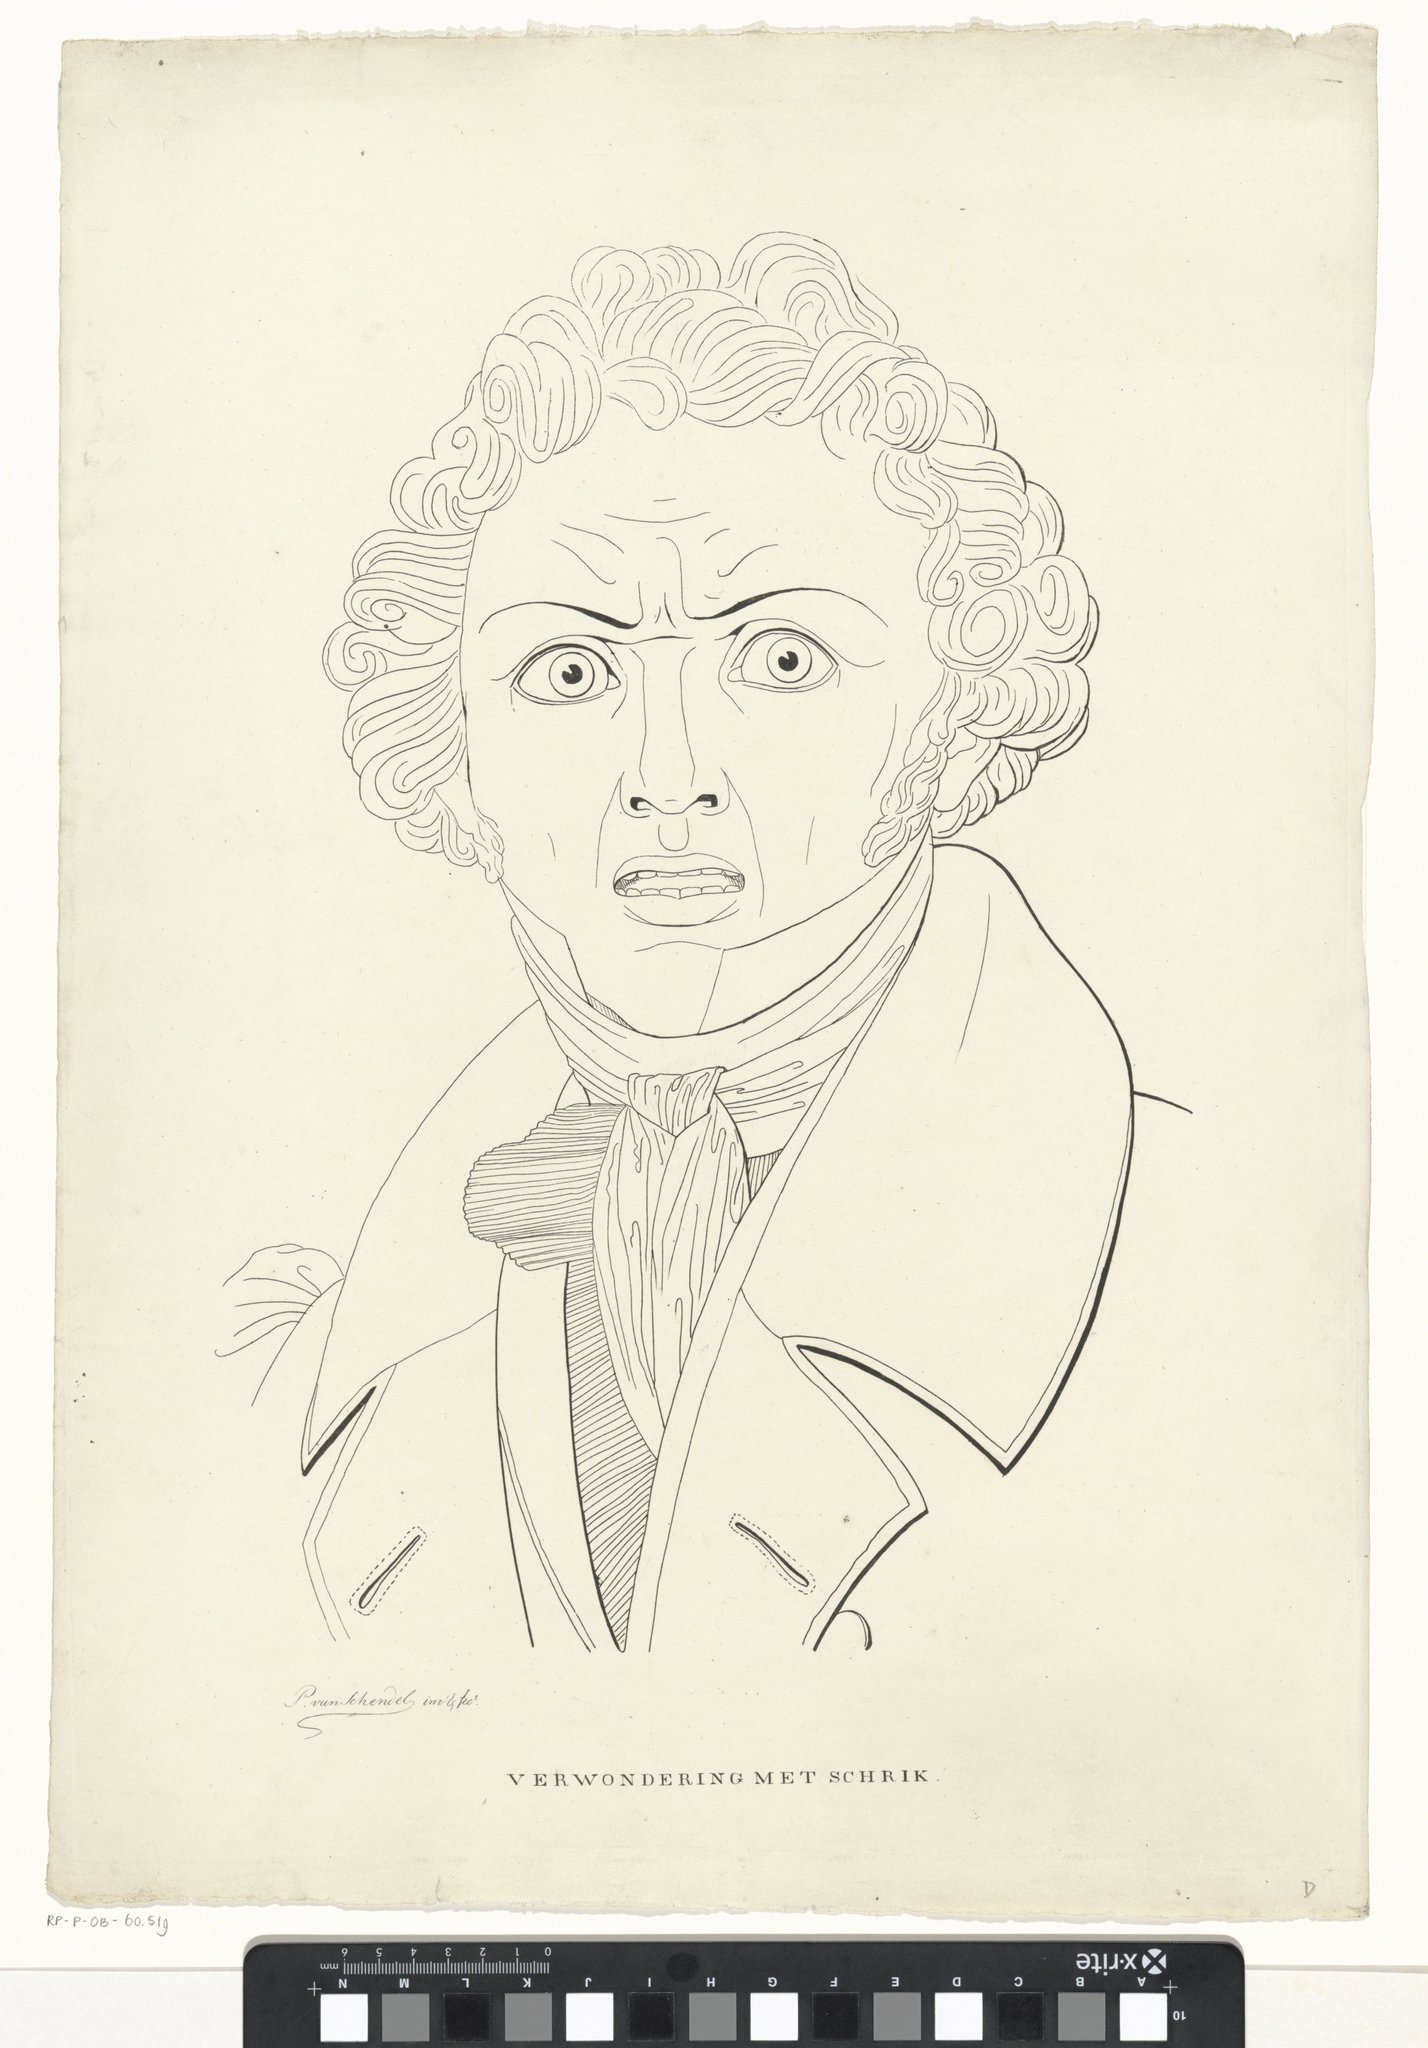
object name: print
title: De Hartstogten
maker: petrus van schendel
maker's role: draughtsman, painter, print maker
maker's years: 1806-1870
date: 1834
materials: paper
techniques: etching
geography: rotterdam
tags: passions, emotions, affections, frowned eyebrows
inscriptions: collector's mark: Lugt 2228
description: Prent was een proefdruk om potentiële afnemers te interesseren voor het werk: Schendel, Petrus van. De hartstogten, afgebeeld in 72 expressiehoofden, Rotterdam: Wed. van der Meer & Verbruggen, 1834